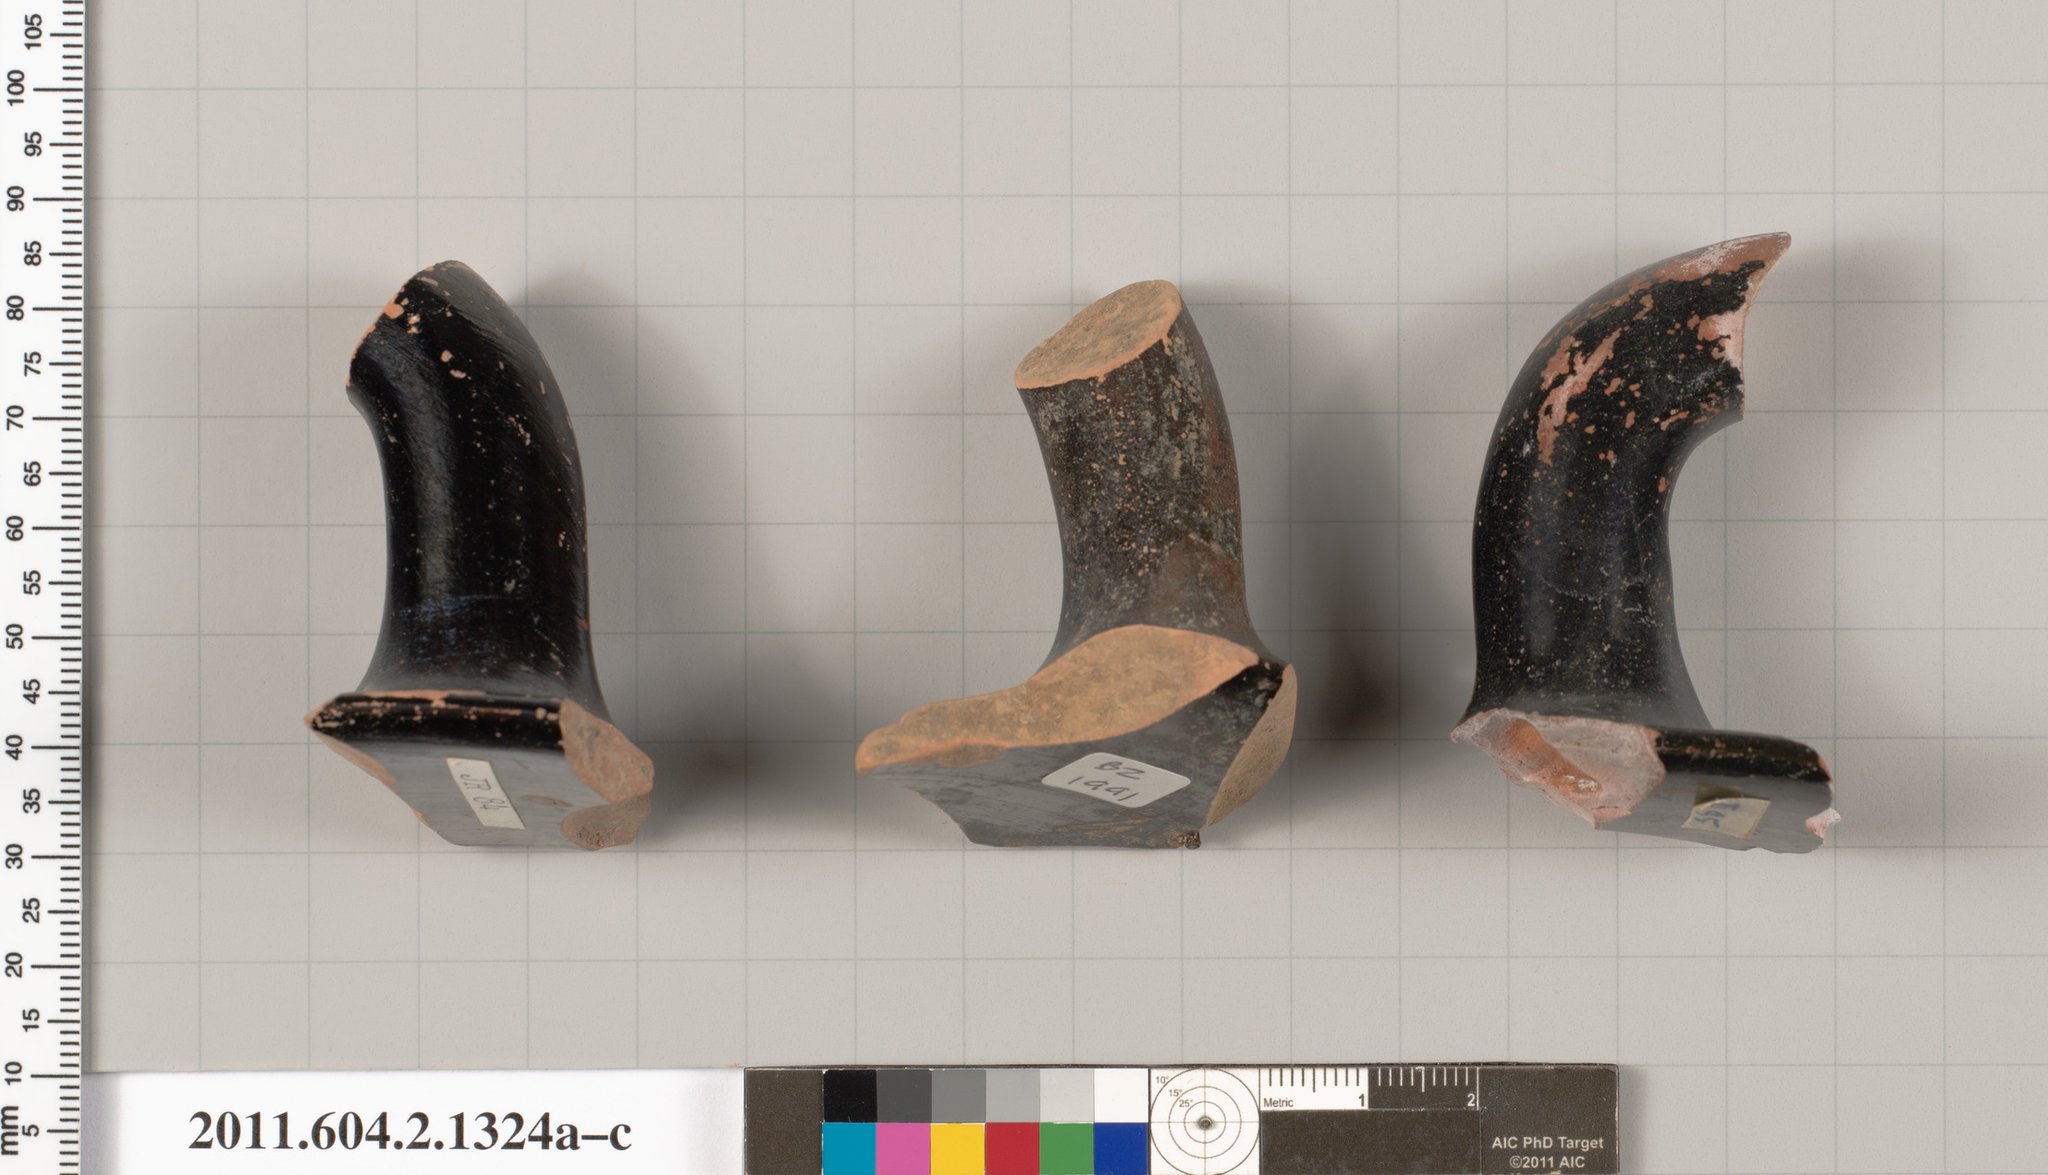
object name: skyphos fragment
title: Terracotta fragments of skyphoi (deep drinking cups)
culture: greek, attic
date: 600-401 BCE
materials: terracotta